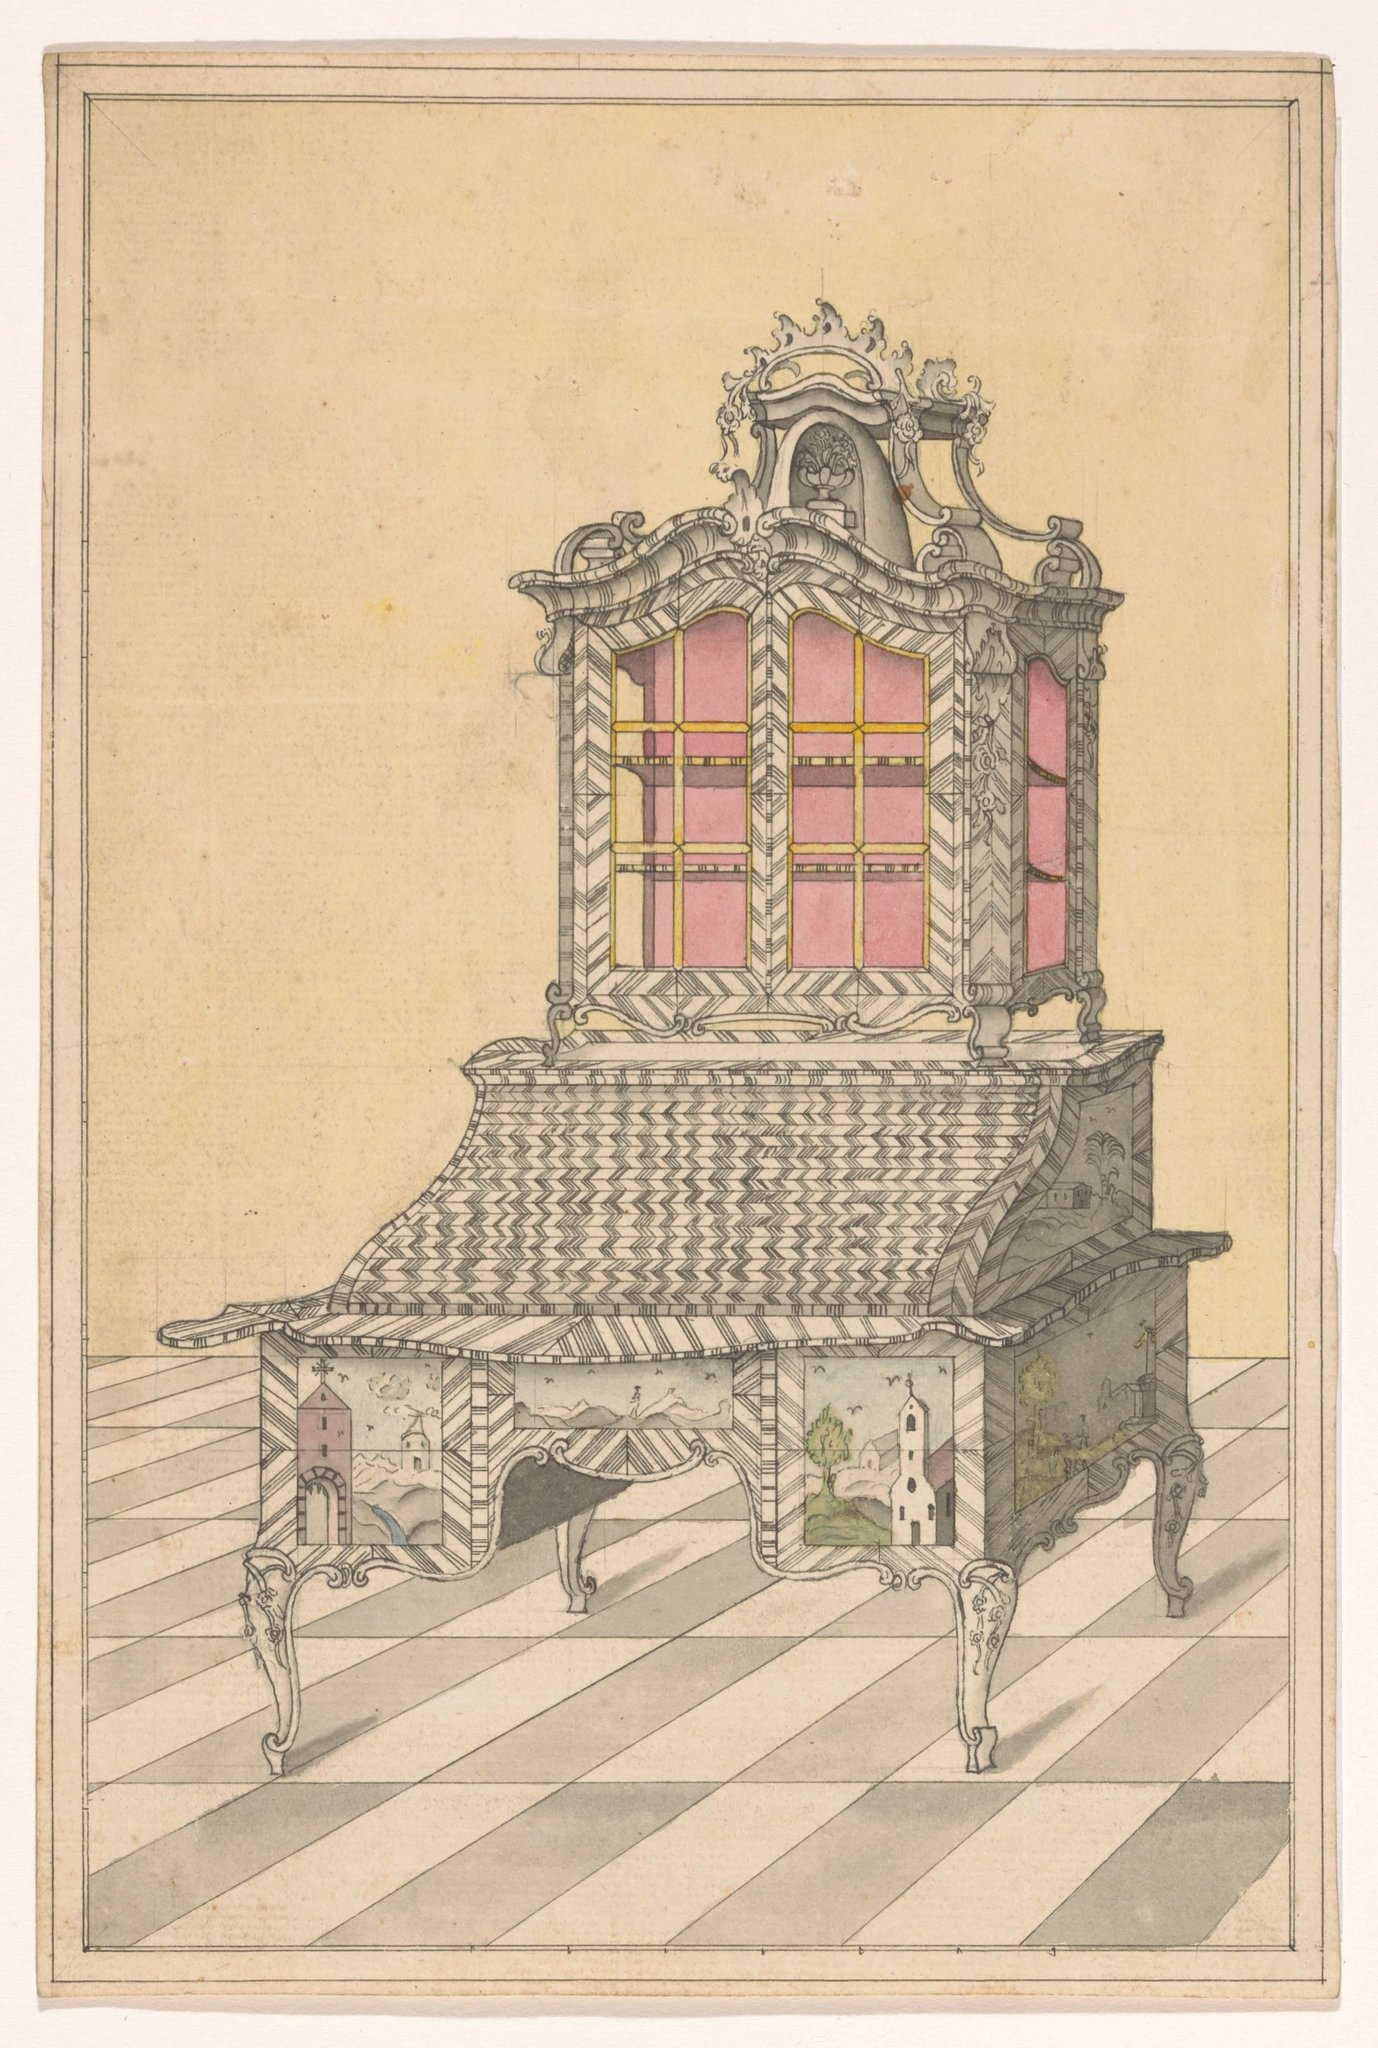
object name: drawing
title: Ontwerp voor een bureau met een vitrineopstand, versierd met marqueterie van landschappen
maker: Anonymous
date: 1760-1770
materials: graphite, ink, watercolor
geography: germany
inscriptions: watermark: ‘[..]HON[IG] onder bijenkorf (?) en wapen onder een lelie.’, size